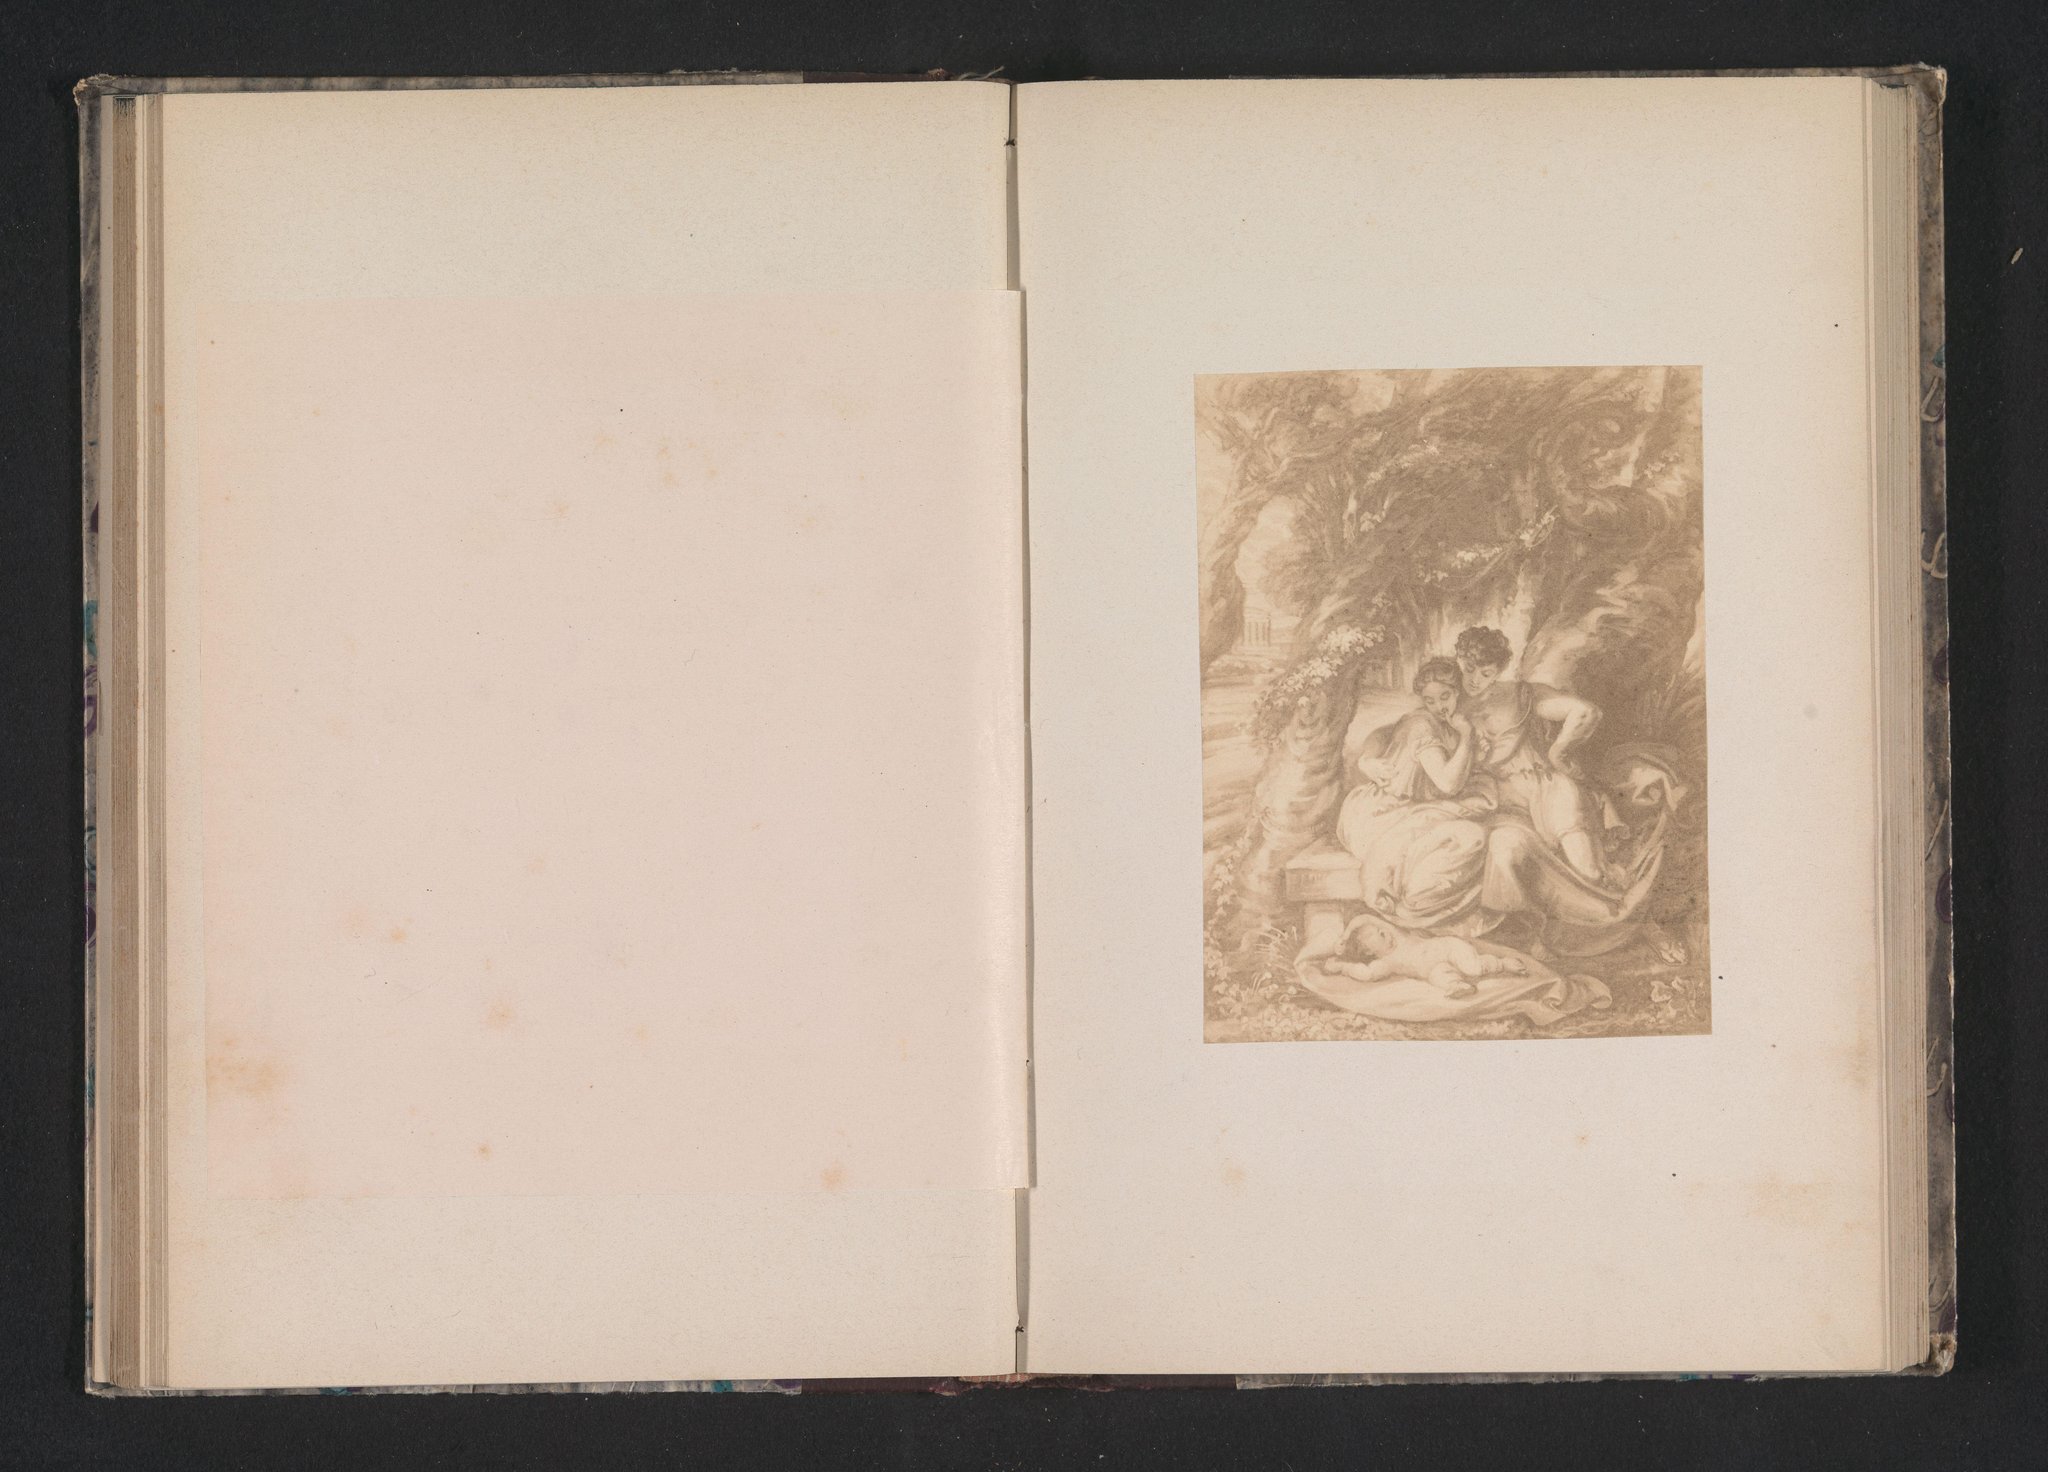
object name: photograph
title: Fotoreproductie van een werk met mogelijk een mythologische voorstelling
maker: Anonymous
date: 1857-1862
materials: photographic support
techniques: albumen print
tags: trees